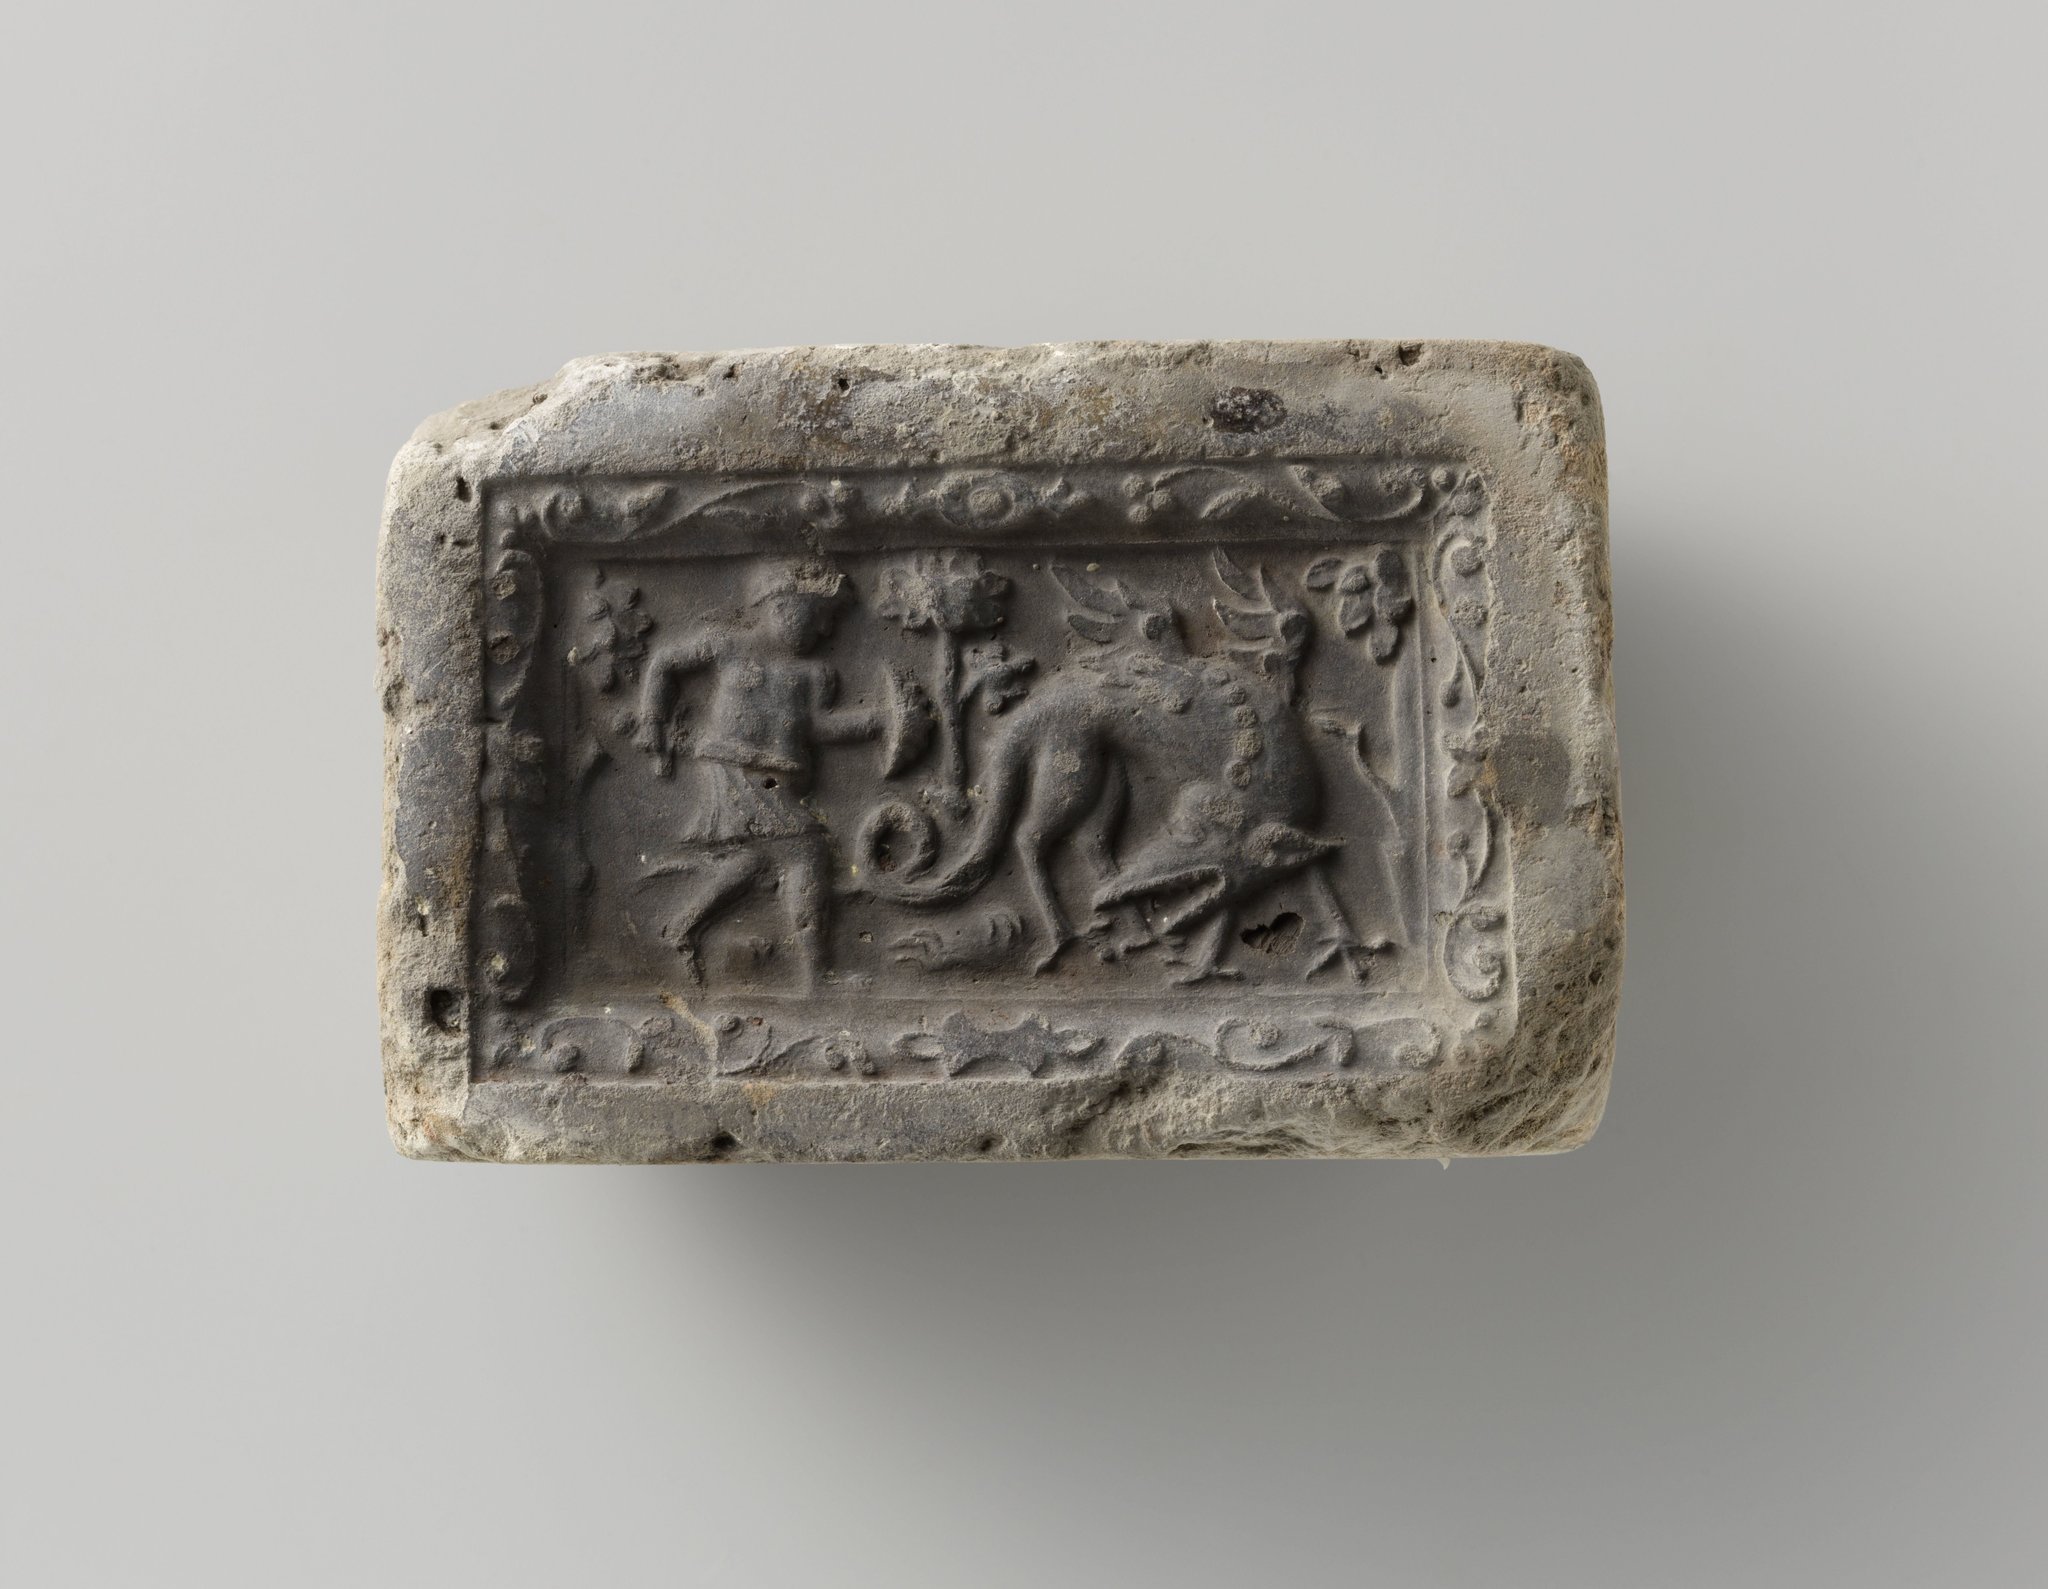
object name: architectural element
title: Haardsteen, waarop St. Michaël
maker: Anonymous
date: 1400-1950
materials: earthenware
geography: southern netherlands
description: Haardsteen, waarop St. Michael. Rijk georneerde rand. Van fijne gebakken aarde.